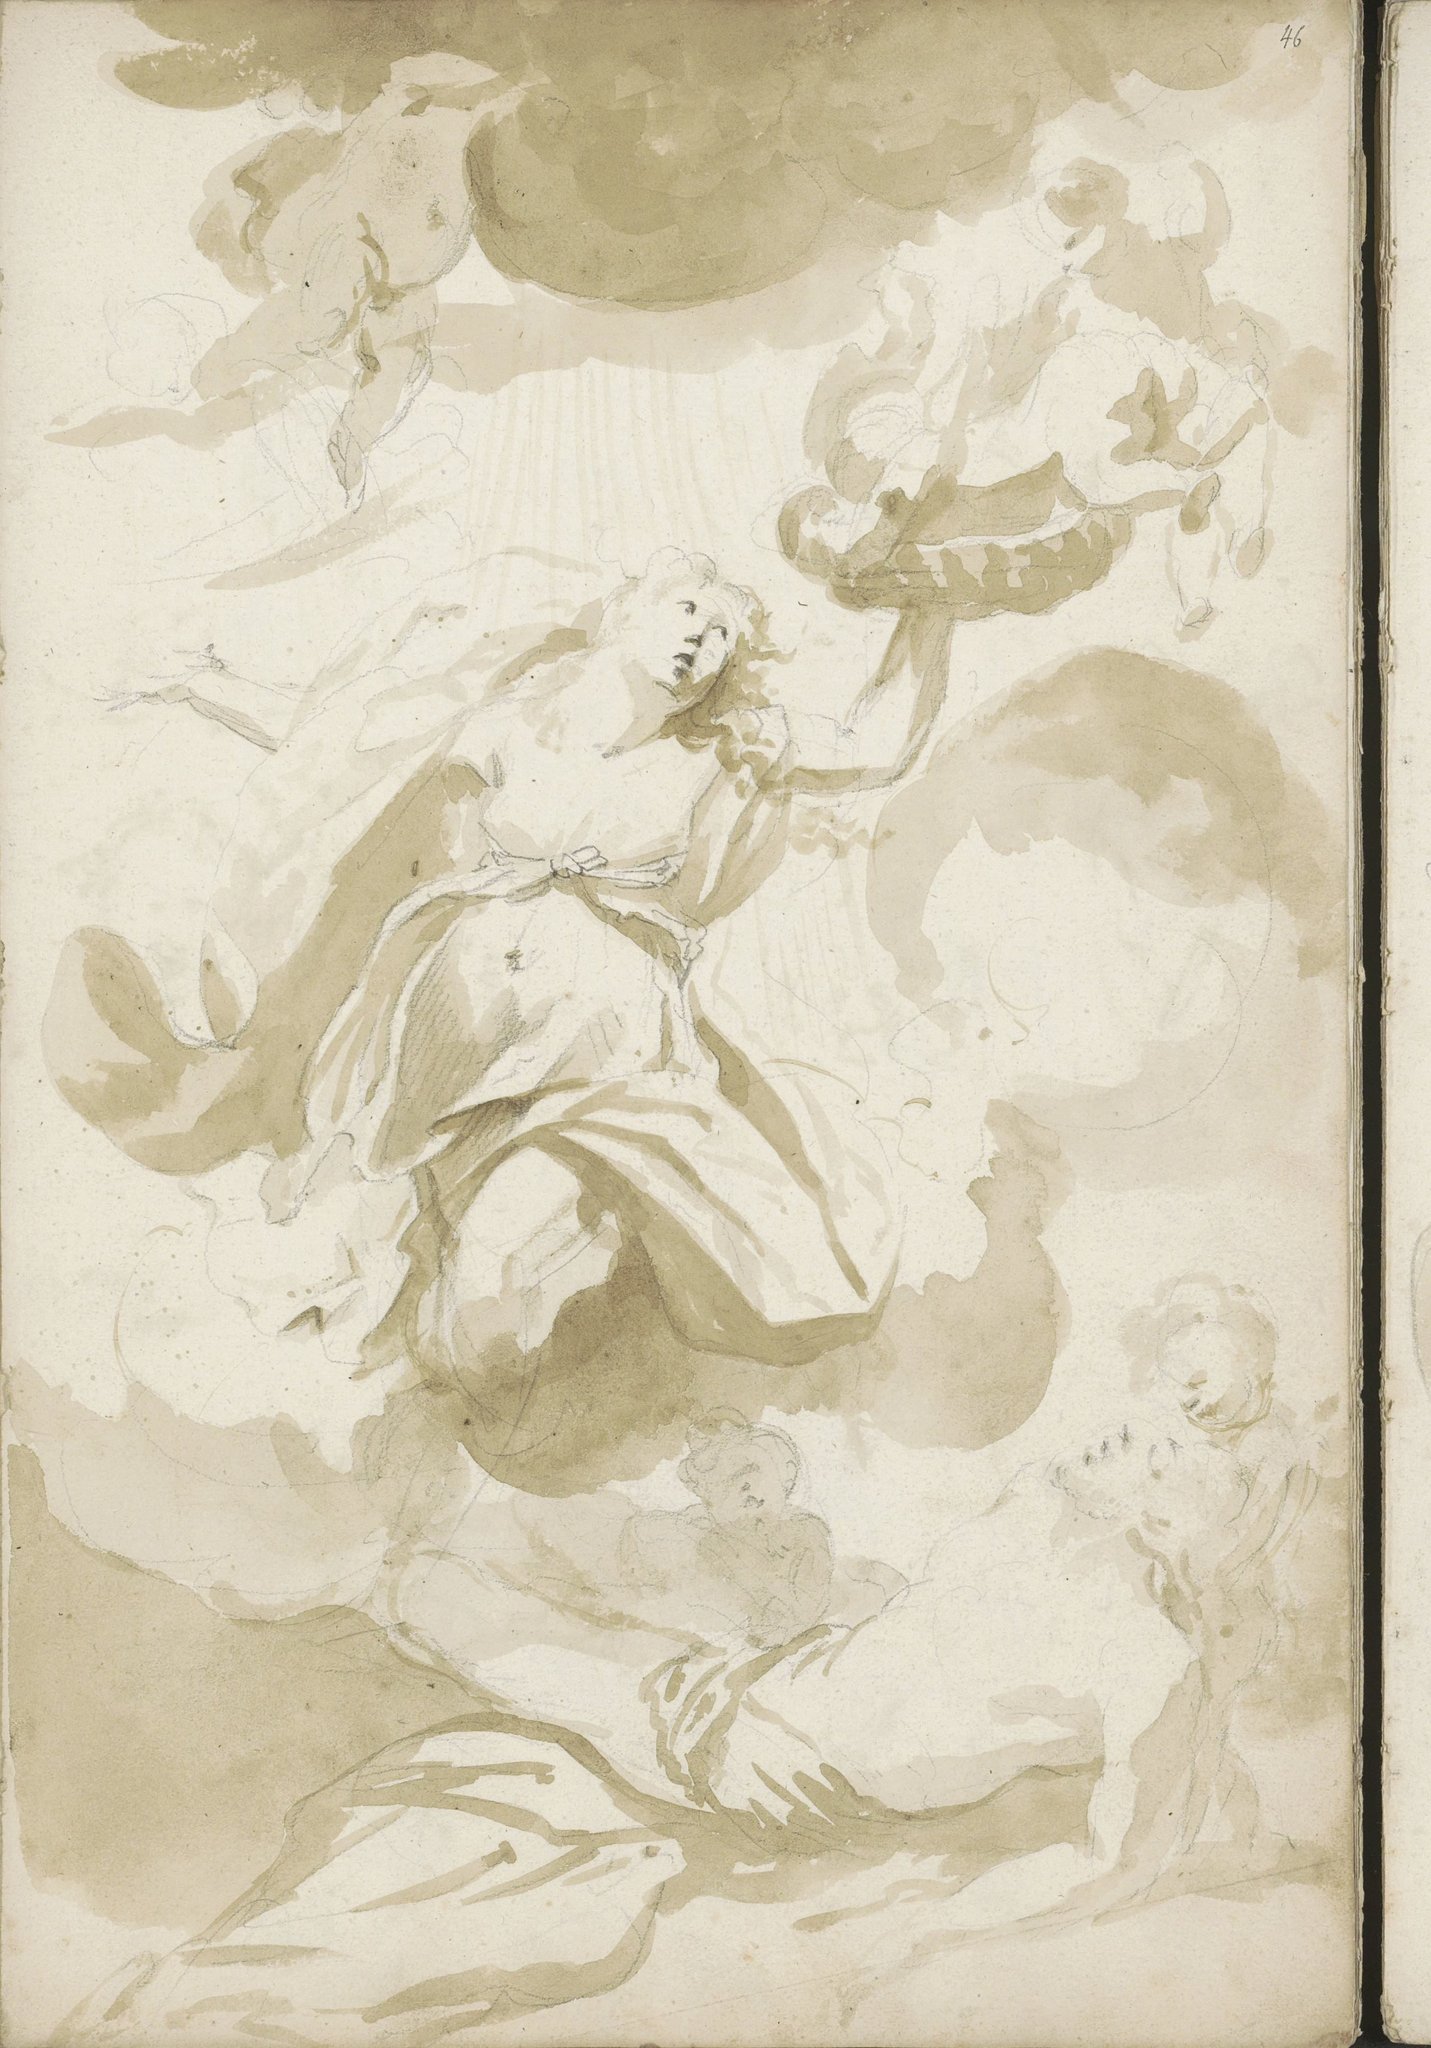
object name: sketchbook leaf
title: Allegorische voorstelling met putti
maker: Anonymous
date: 1650-1799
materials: ink, paper, pencil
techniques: brush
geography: italy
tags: garland, wreath, lying figure, cupids: 'amores', 'amoretti', 'putti'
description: Een putto reikt een vrouw die ten hemel stijgt een krans aan. Tevens een studie van een putto die het hoofd draagt van een lliggende man in een lendendoek. Bladzijde 46 uit een schetsboek met 72 bladzijden.